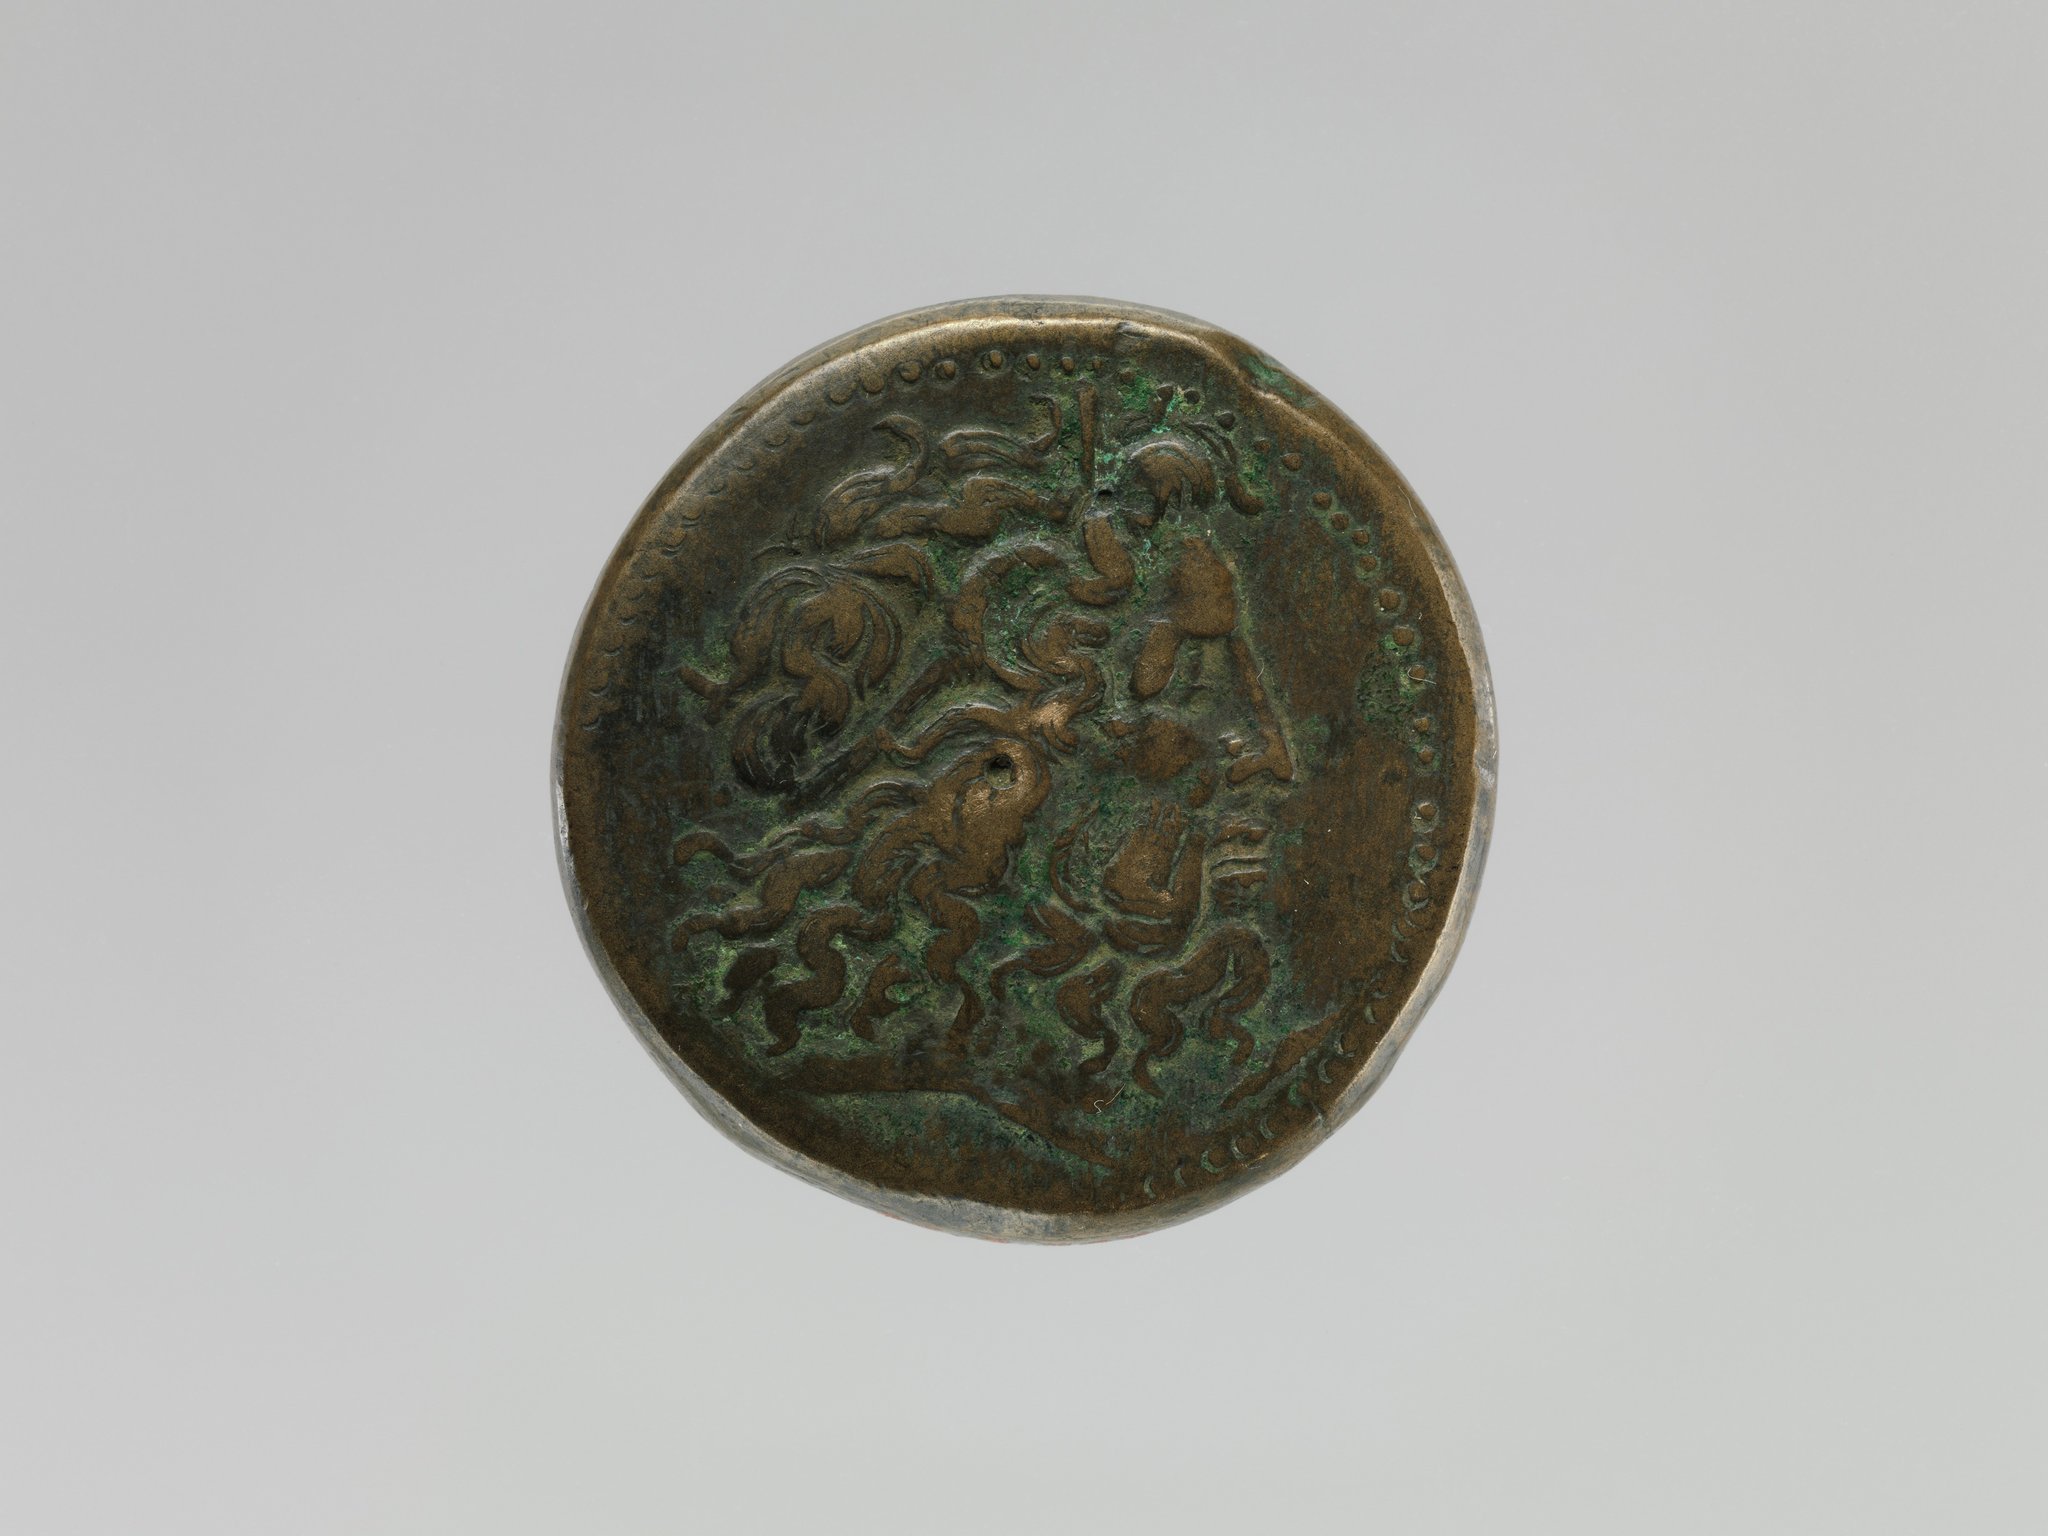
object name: coin, ptolemy ii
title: Coin of Ptolemy II from a Ptolemaic hoard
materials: bronze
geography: egypt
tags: eagles,coins